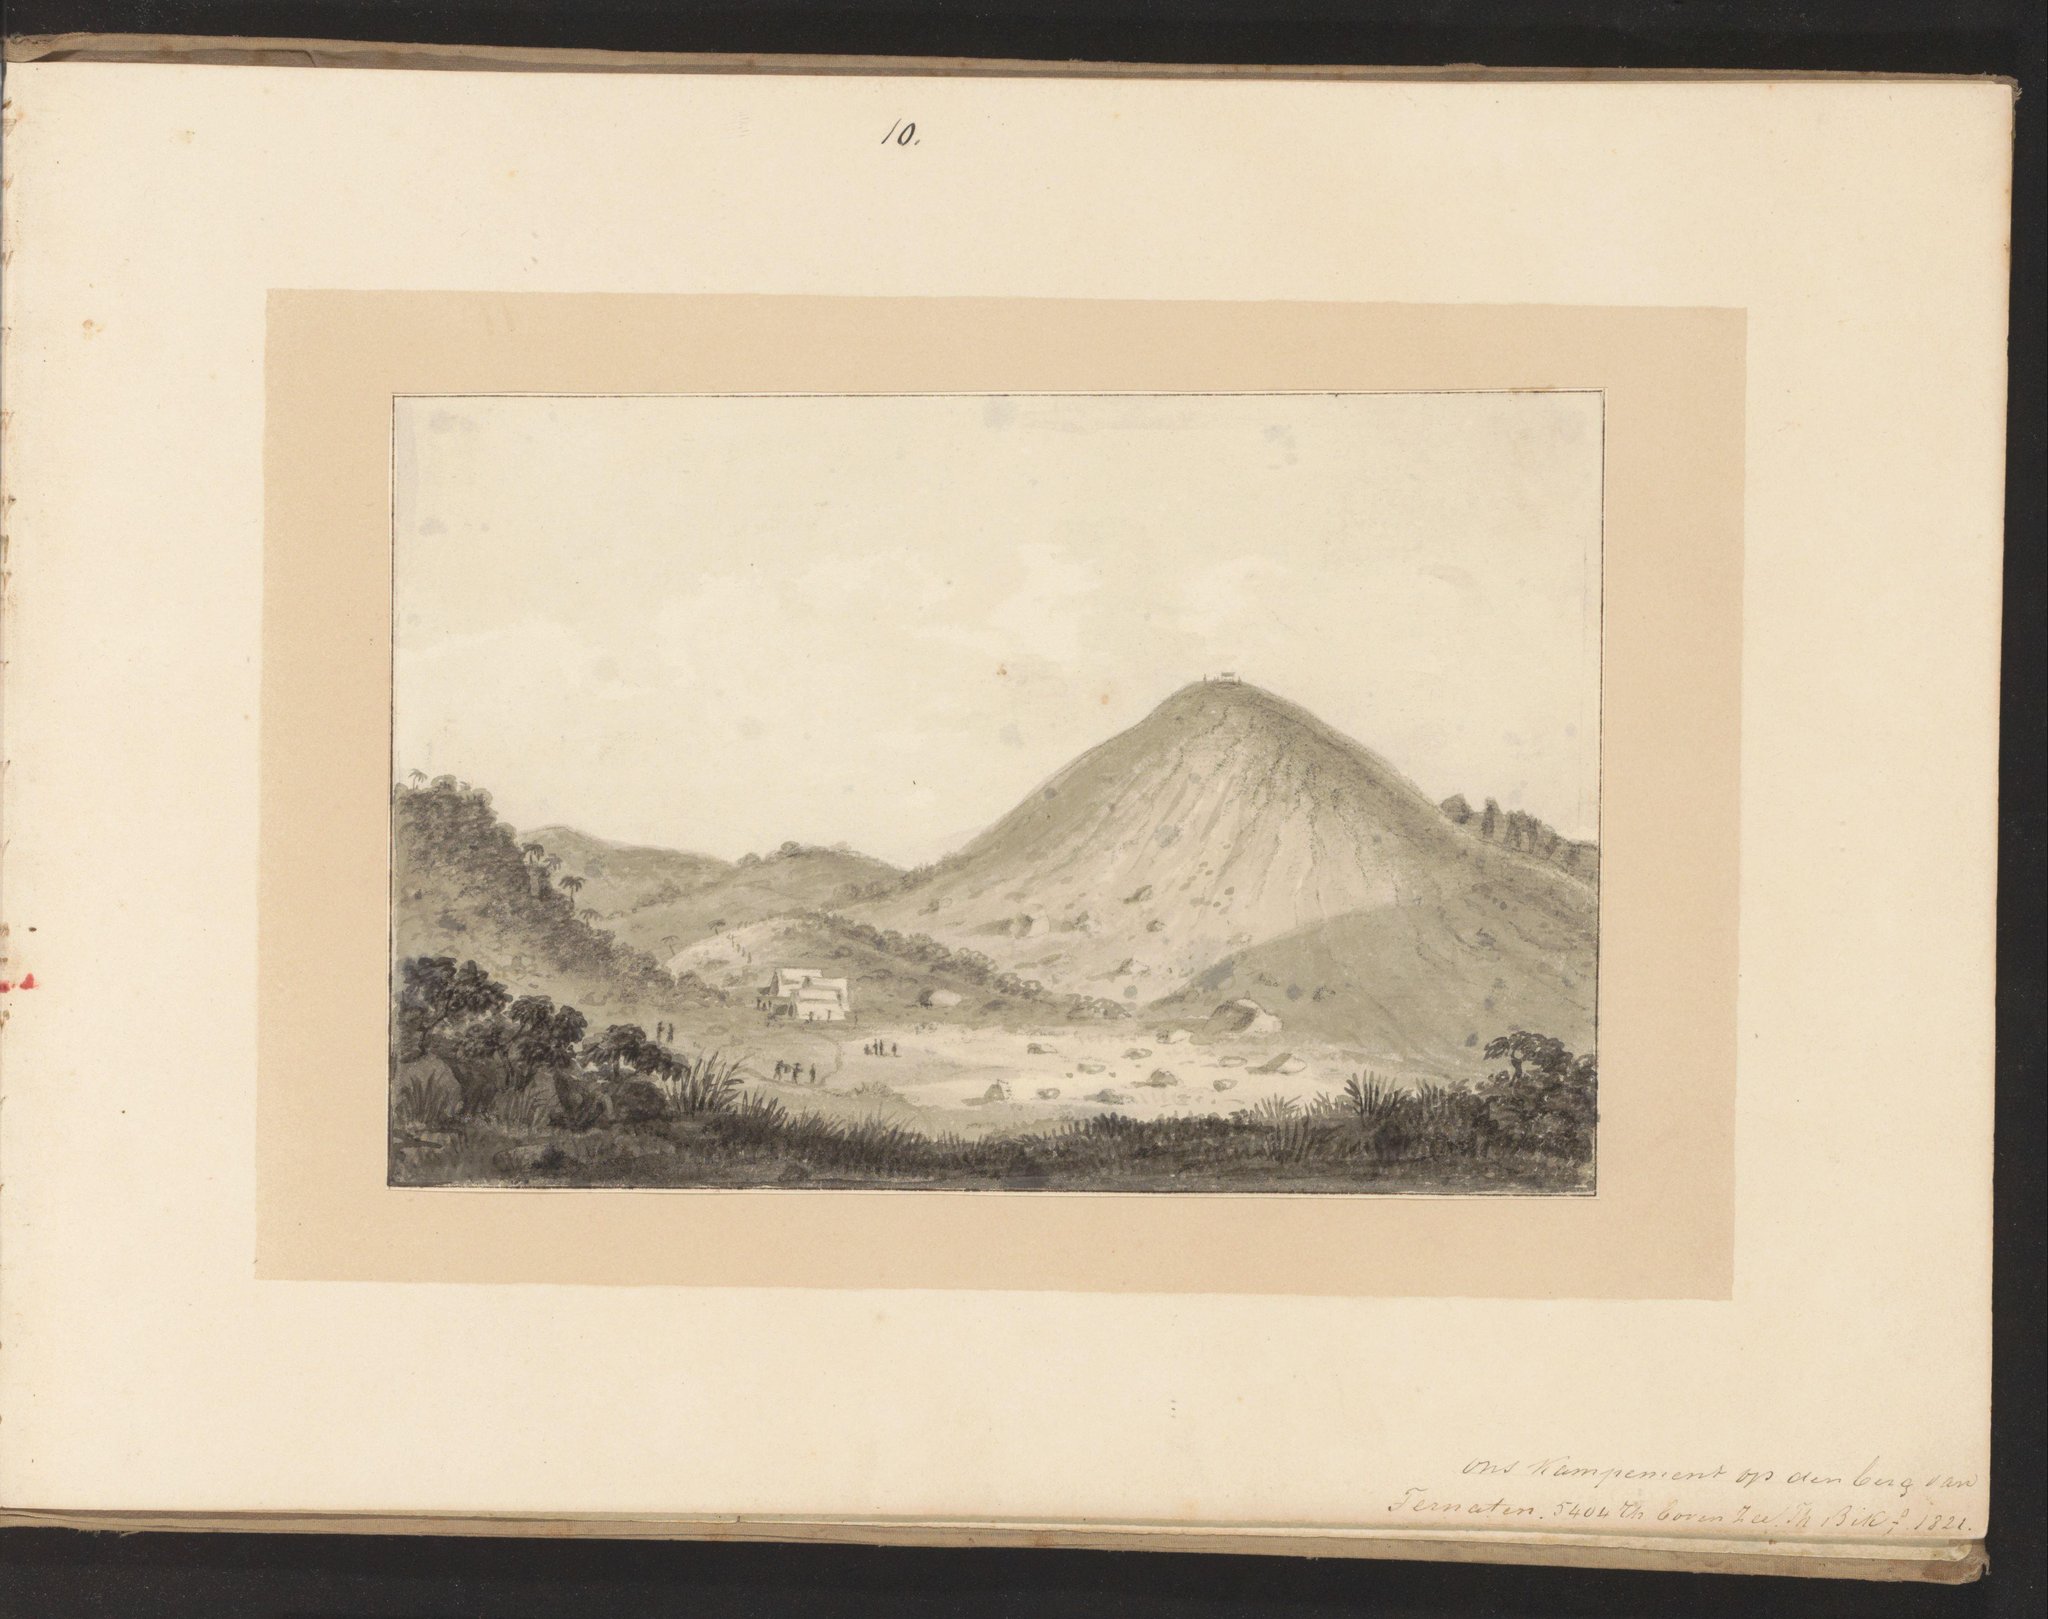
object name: album leaf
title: Kampement op de berg van Ternate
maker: jannes theodorus bik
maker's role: draughtsman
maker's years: 1796-1872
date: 1821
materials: chalk, ink, paper, pencil, watercolor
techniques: brush, pen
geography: ternate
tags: cold lava, tent-camp, mountains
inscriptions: signature and date: ‘Th. Bik f. 1821.’, annotation: ‘ons Kampement op den berg van/ Ternaten. 5404 r[...] boven zee.’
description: Blad 10 uit een album met 14 tekeningen en een prent.